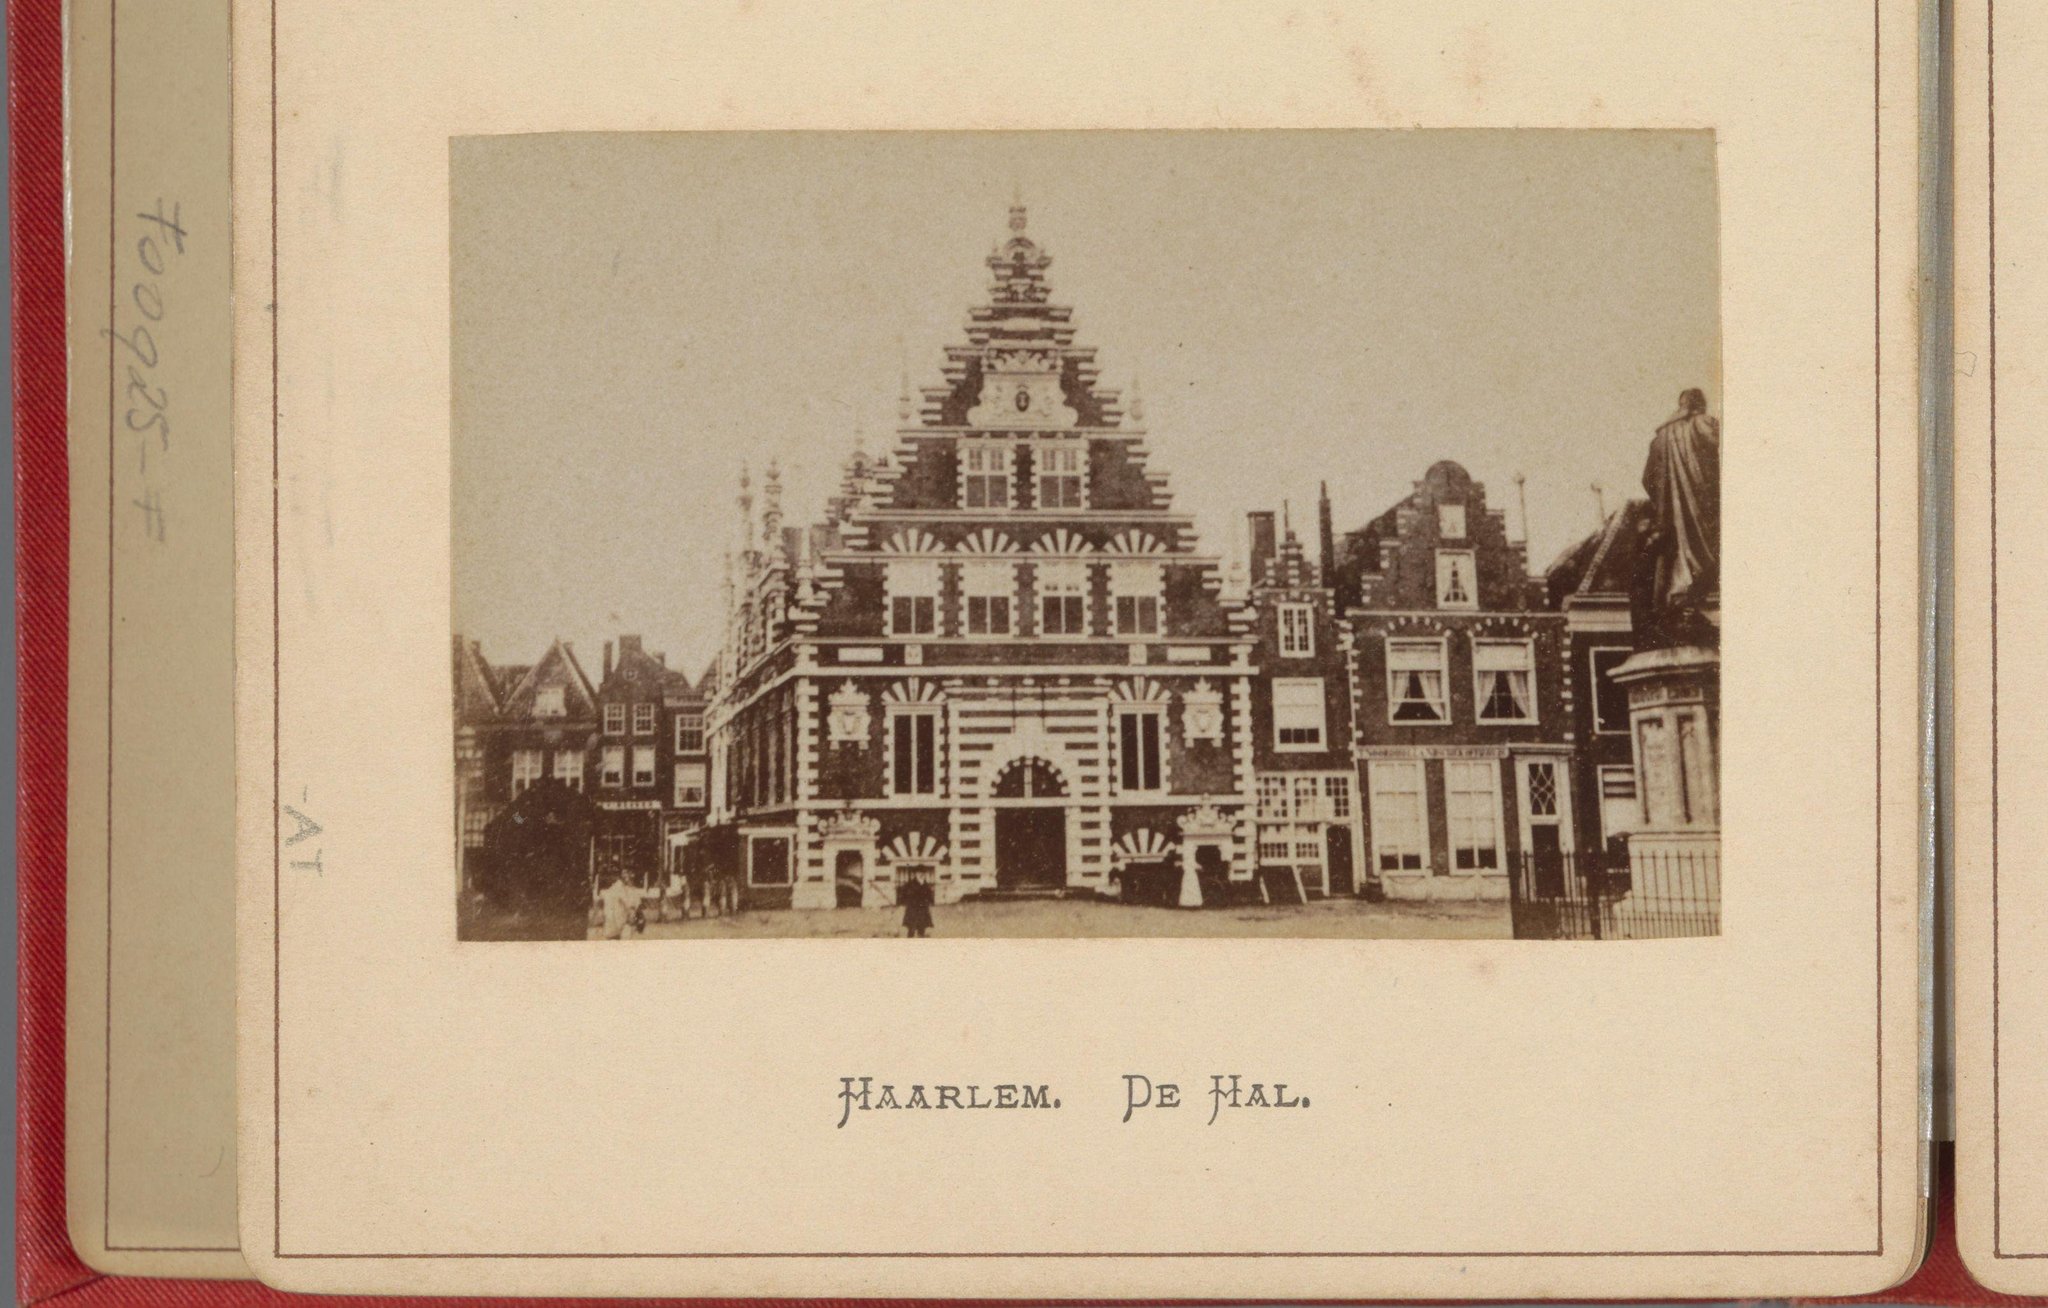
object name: album leaf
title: Haarlem. De Hal.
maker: andries jager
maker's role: publisher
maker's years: 1825-1905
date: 1860-1900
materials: cardboard, photographic support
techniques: albumen print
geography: haarlem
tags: façade (of house or building), square, place, circus, etc. (+ city(-scape) with figures, staffage)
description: Onderdeel van Fotoalbum met opnames van steden in Noord- en Zuid-Holland en Utrecht.